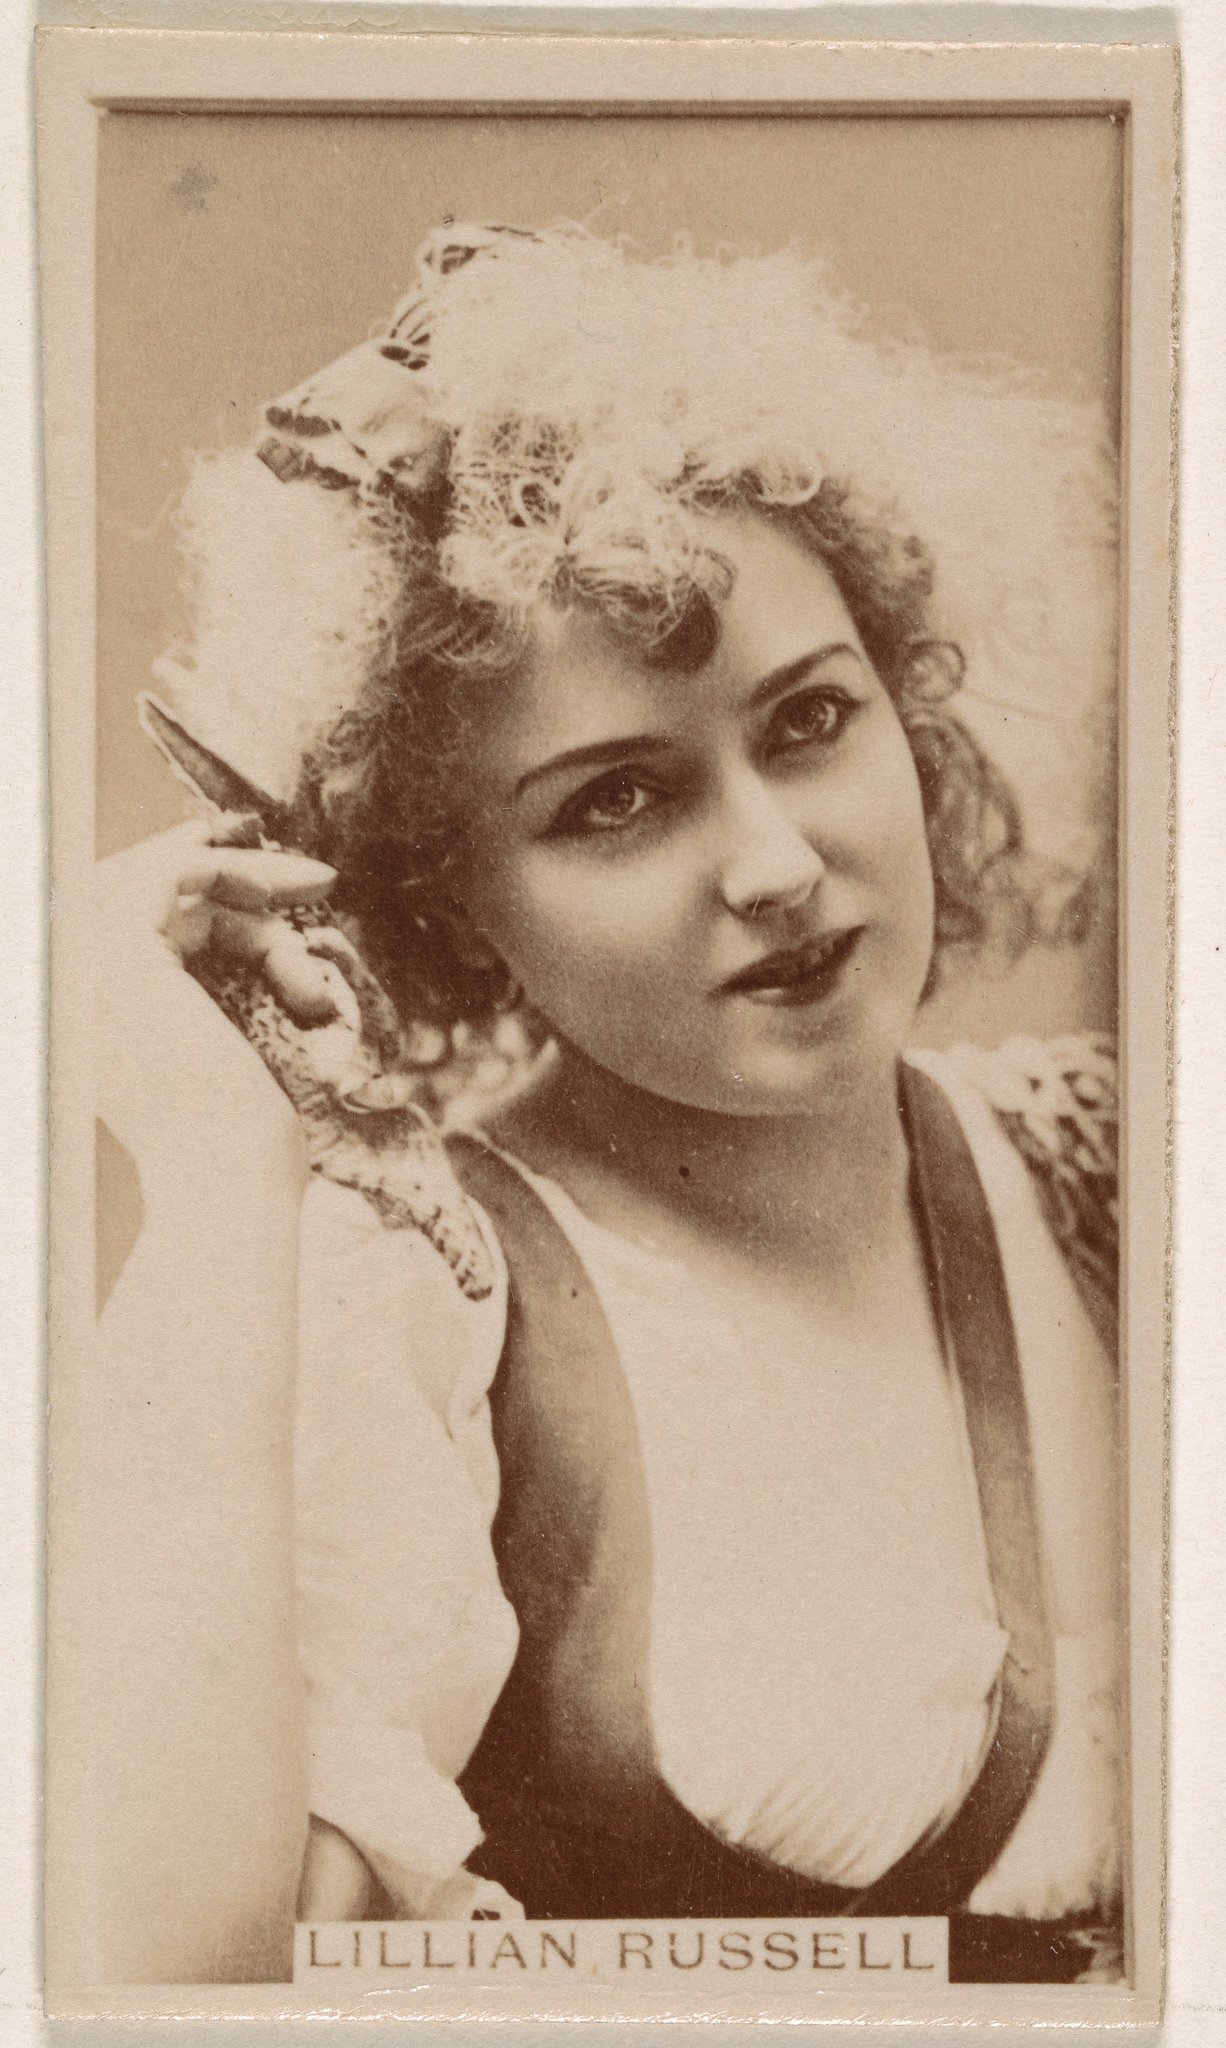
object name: photograph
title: Lillian Russell, from the Actresses series (N245) issued by Kinney Brothers to promote Sweet Caporal Cigarettes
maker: kinney brothers tobacco company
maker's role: publisher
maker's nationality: american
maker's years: 1869-2011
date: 1890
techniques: albumen silver print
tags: portraits,women,actresses